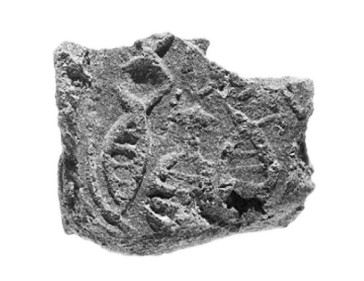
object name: sealing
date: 1981-1640 BCE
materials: mud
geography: egypt